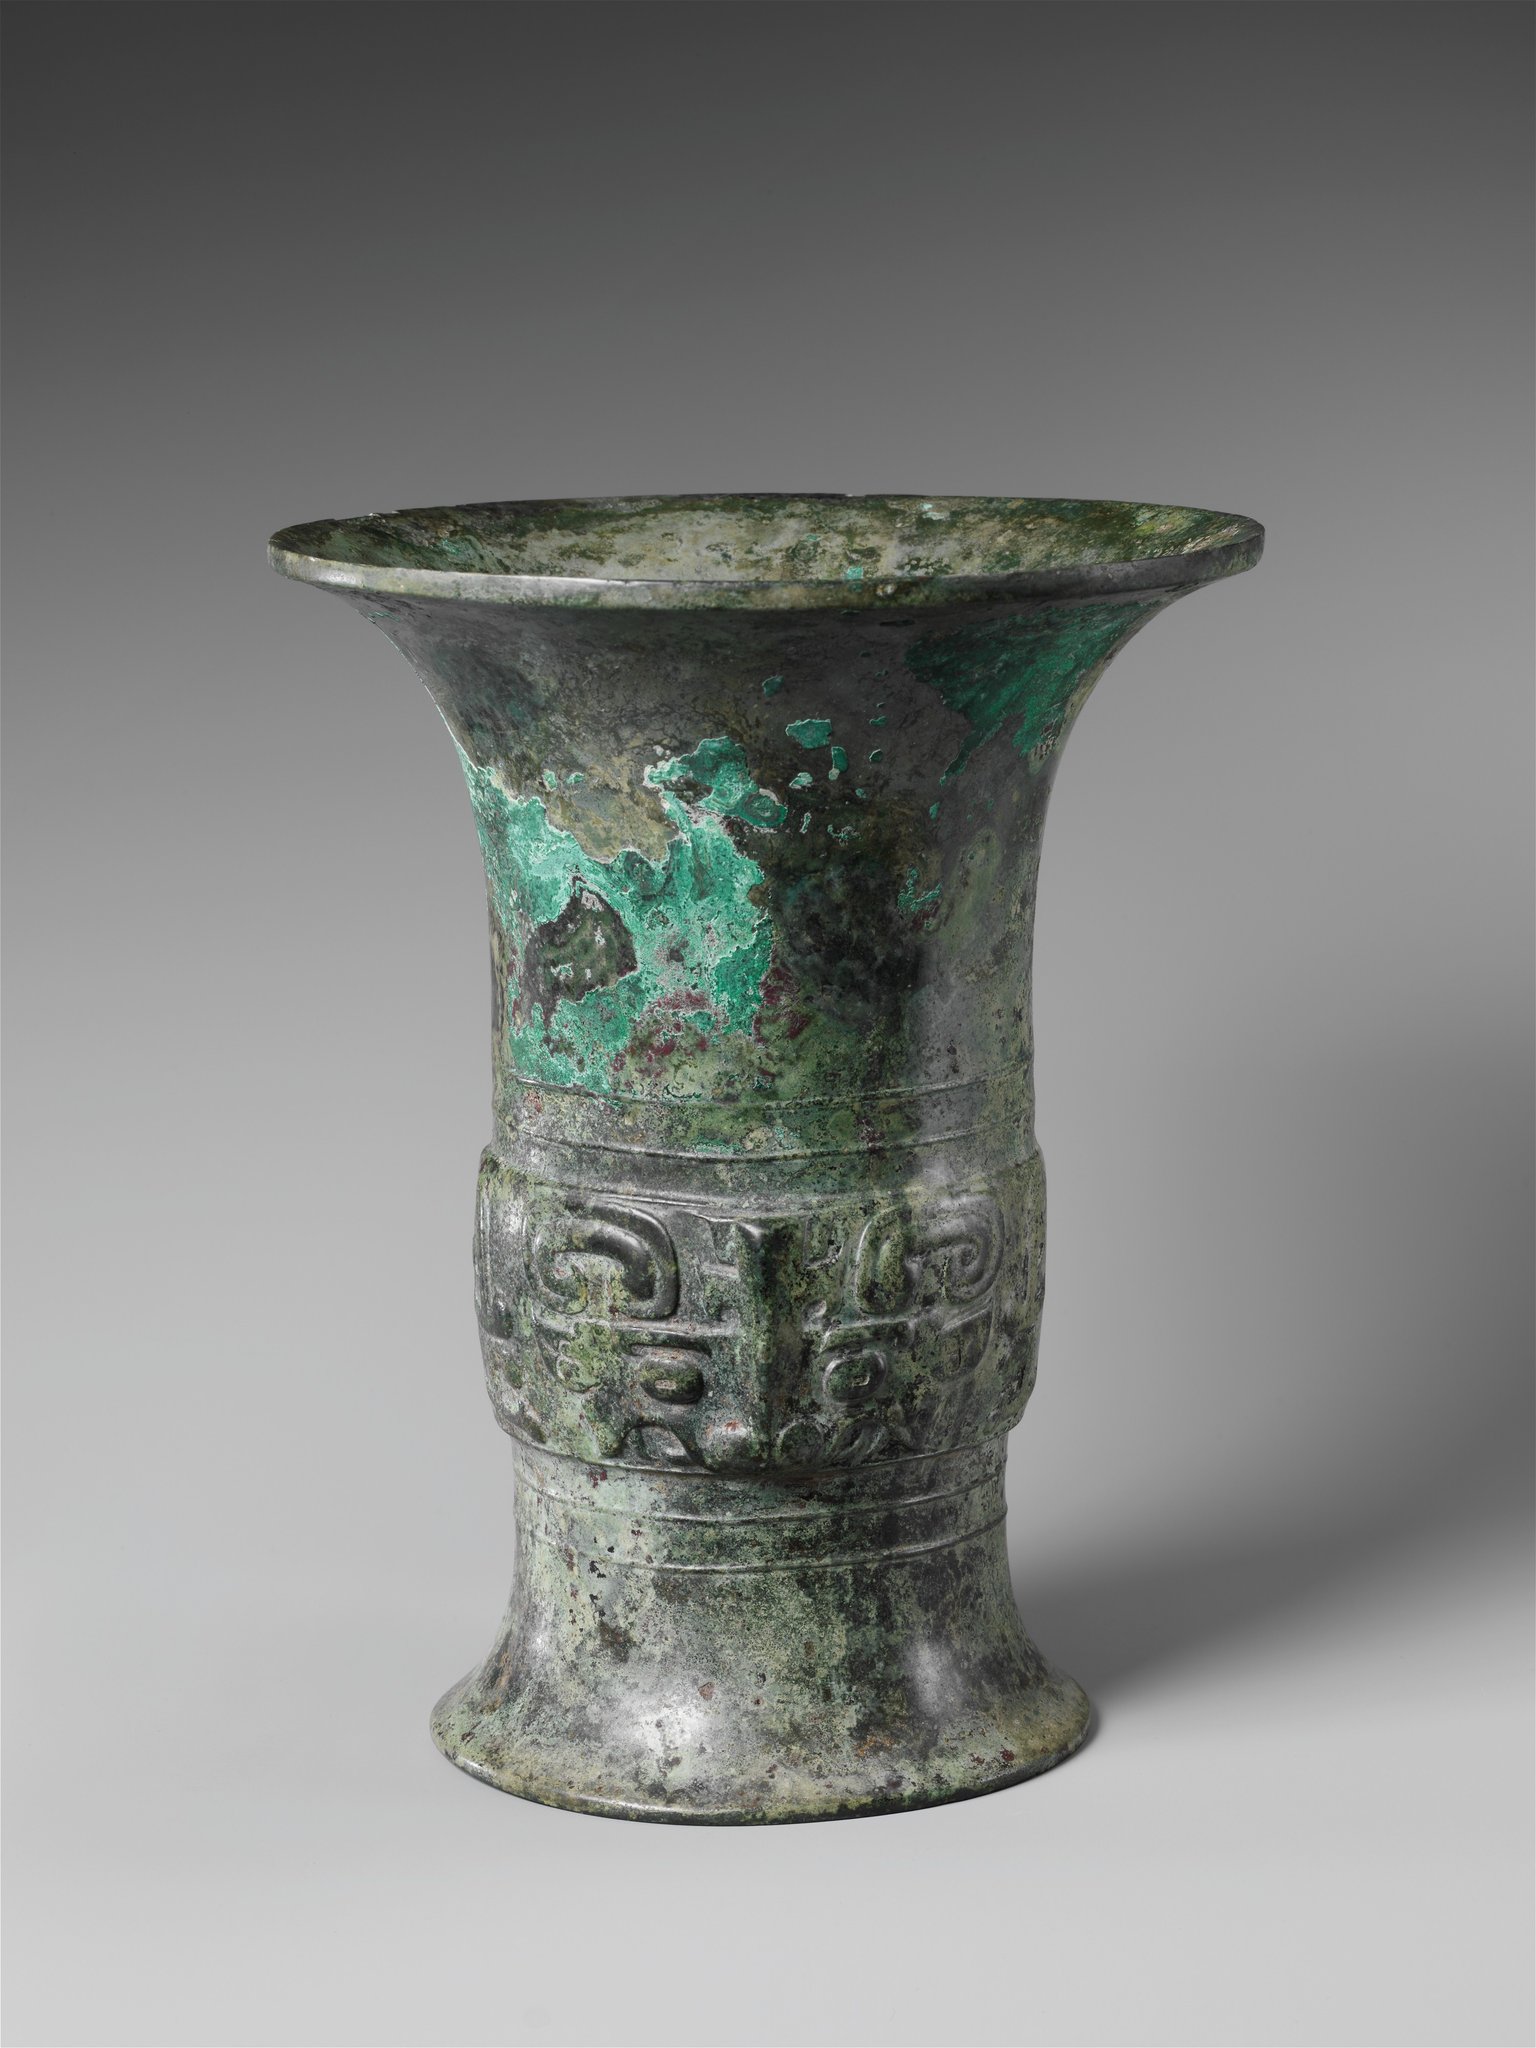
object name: wine vessel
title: Wine vessel ( Zun)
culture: chinese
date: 1300-901 BCE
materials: bronze